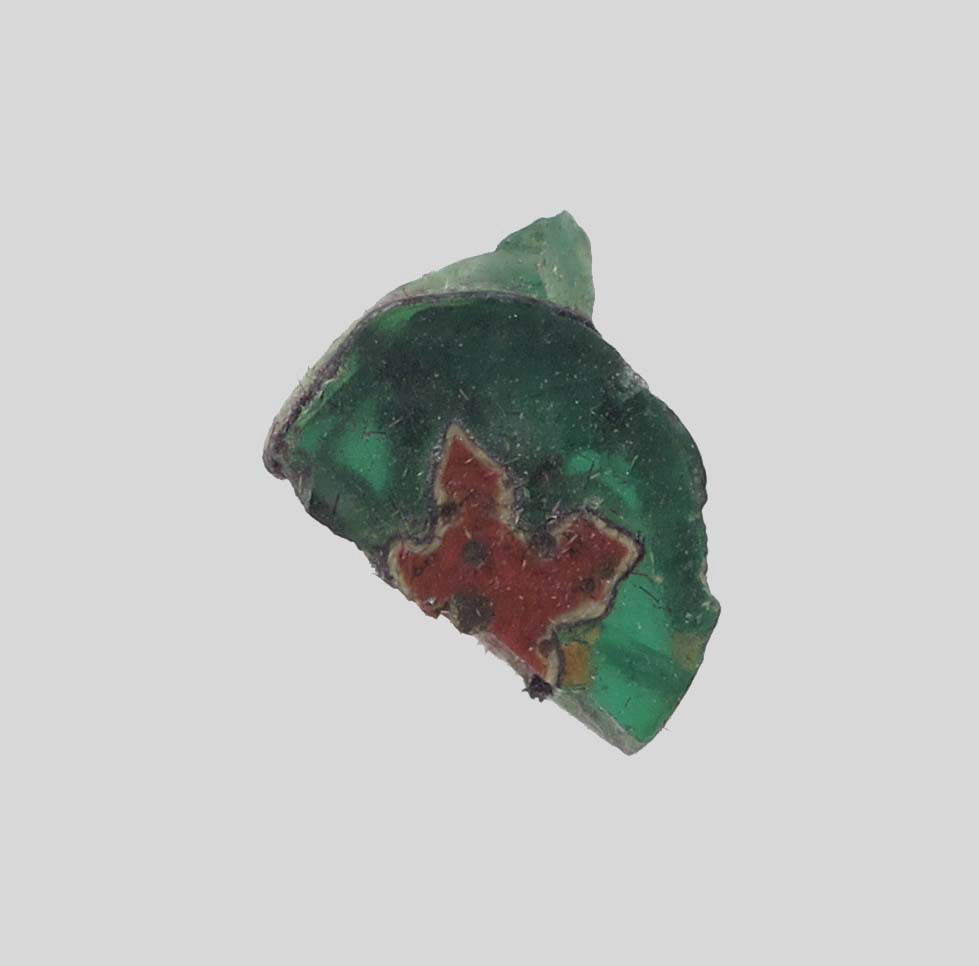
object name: enamel fragment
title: Fragment of a Flower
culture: french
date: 1001-1100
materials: enamel, gold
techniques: enamel